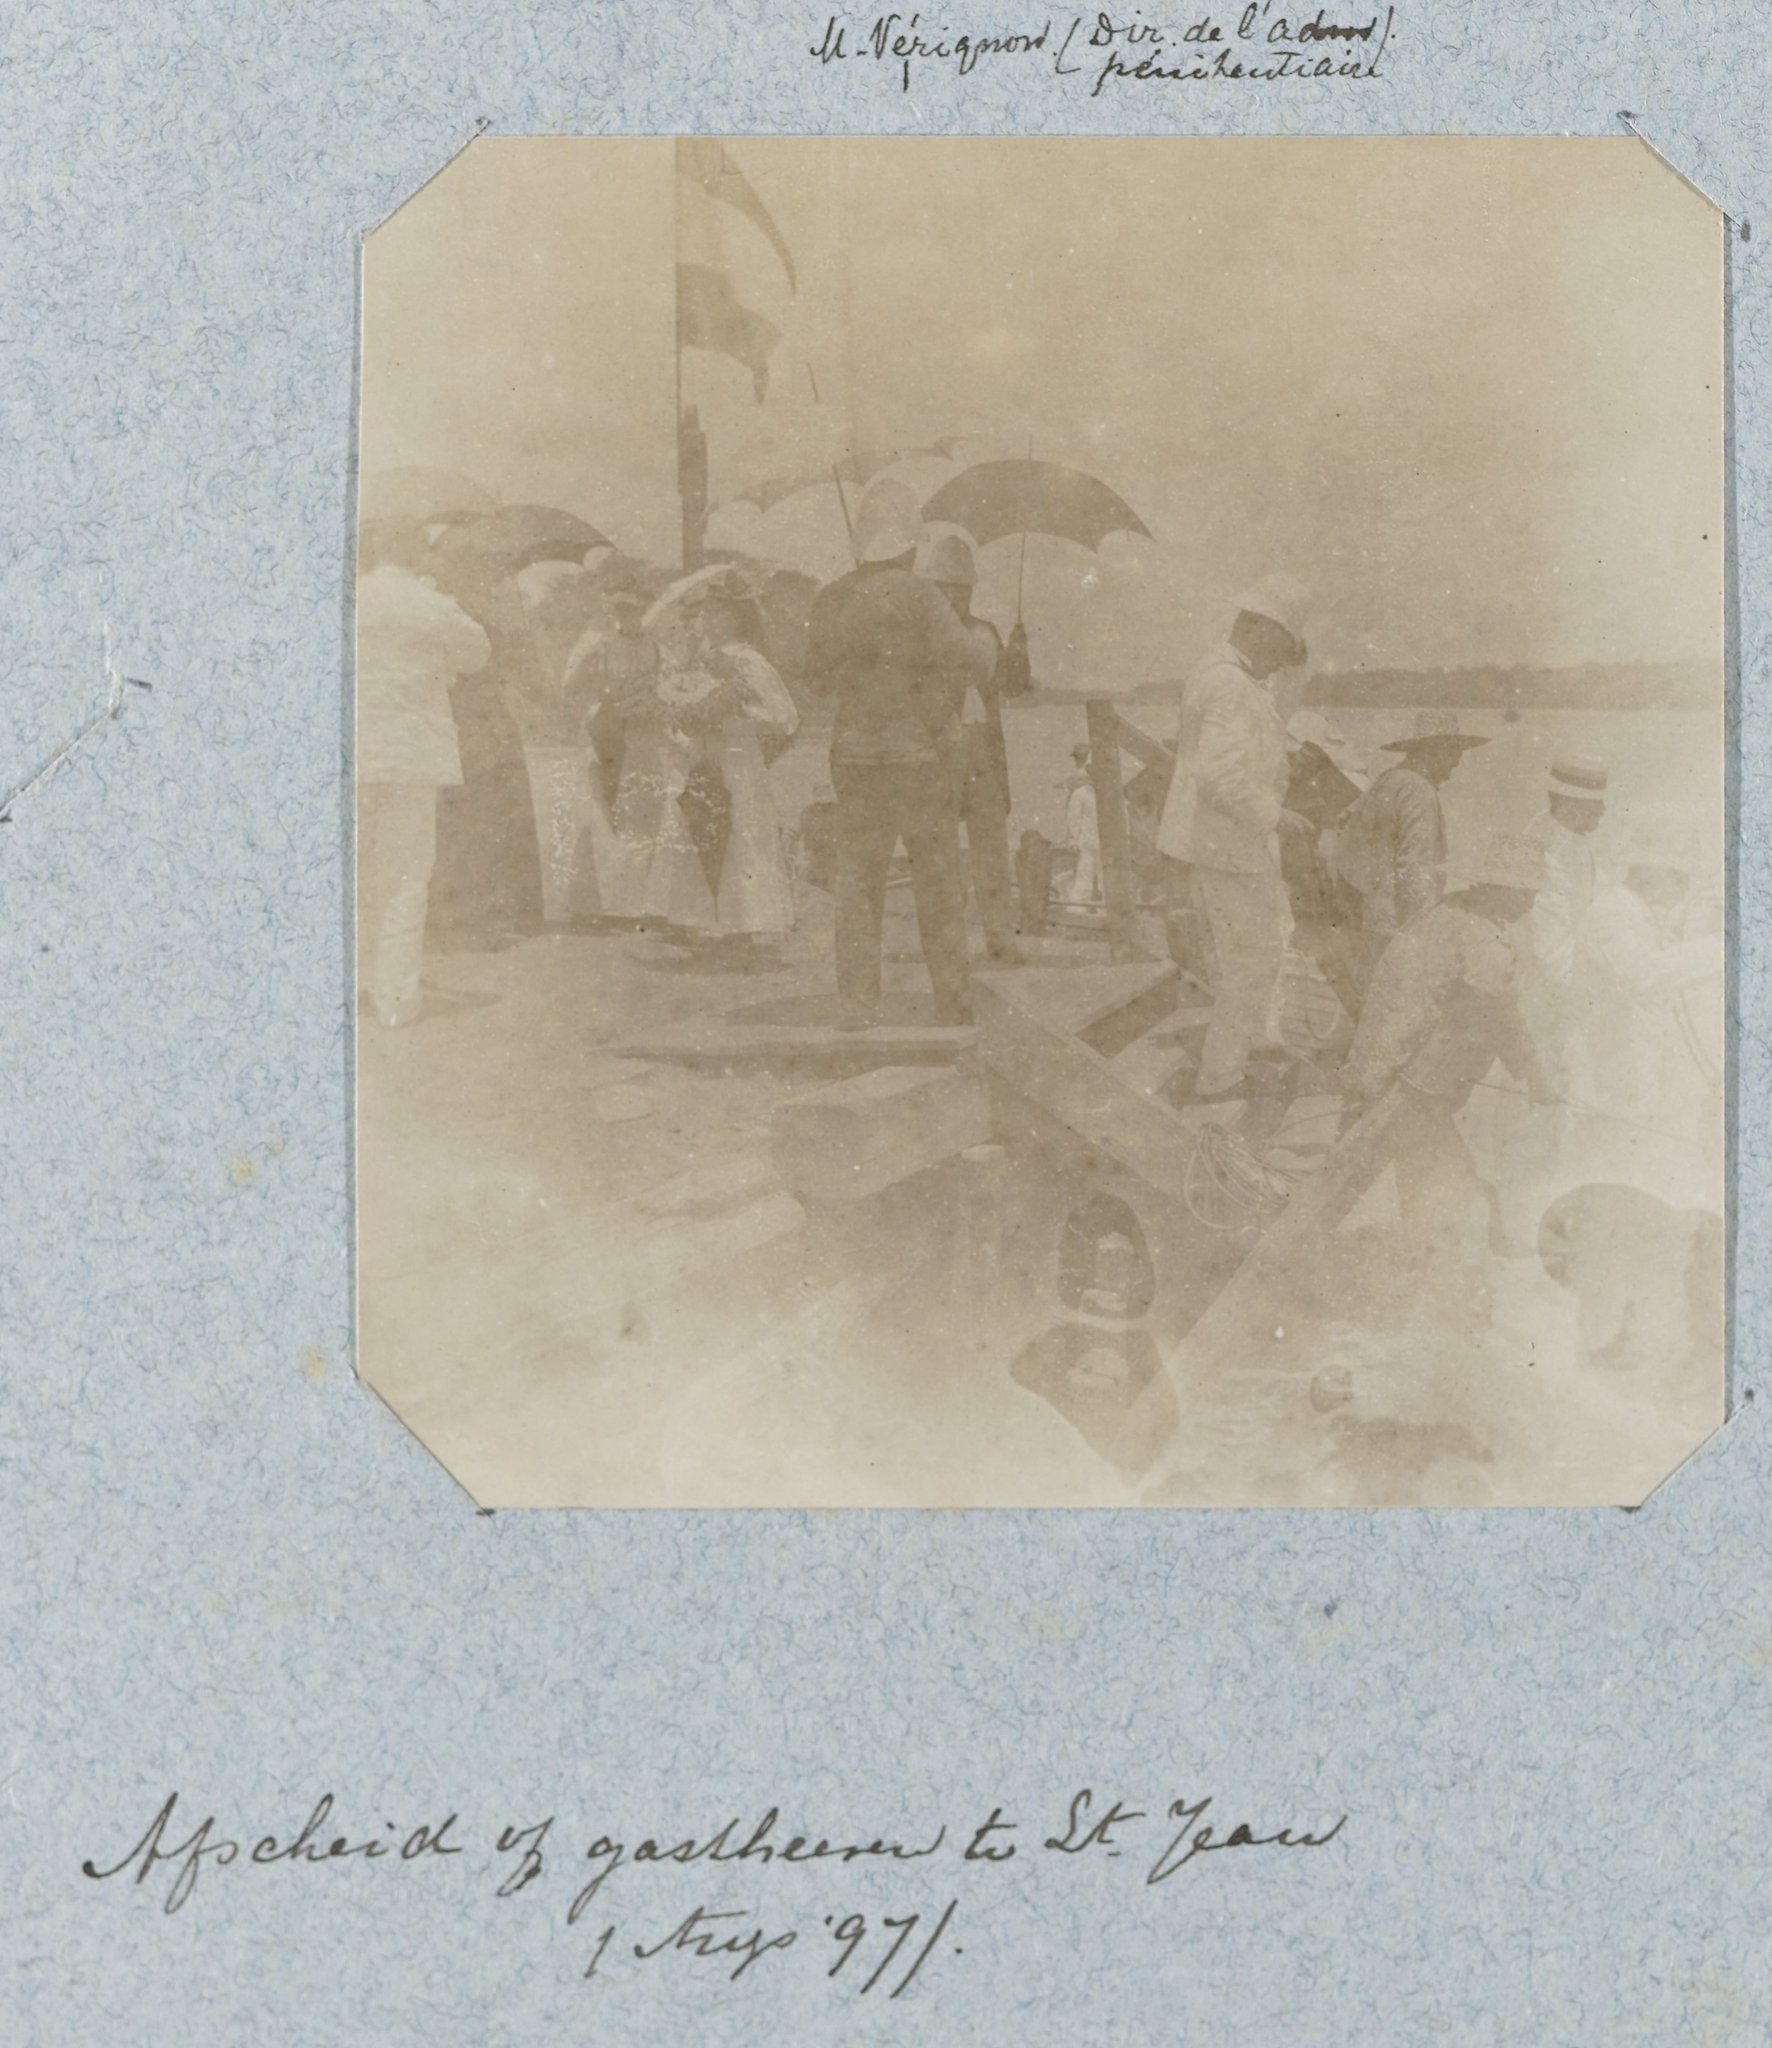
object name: photograph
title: Afscheid v/d gastheeren te St. Jean. (Augs. '97)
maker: théodore van lelyveld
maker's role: painter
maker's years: 1867-1954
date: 1808-1897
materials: photographic support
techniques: collodion silver print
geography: suriname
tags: workhouse, penal camp, penitentiary, chain gang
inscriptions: inscription: ‘Afscheid v/d gastheeren te St. Jean. (Augs. '97). / M. Vérignord (Dir. de l'adms. pénitentiare).’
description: Afscheid van de gastheren tijdens het bezoek aan de Franse strafkolonie te St. Jean (Saint-Jean-du-Maroni) in Guyana, augustus 1897. Een groep Europese mannen en vrouwen gaan bij een steiger aan boord van een boot. Fotoafdruk in een fotoalbum van Théodore van Lelyveld over Suriname uit 1895-1898.